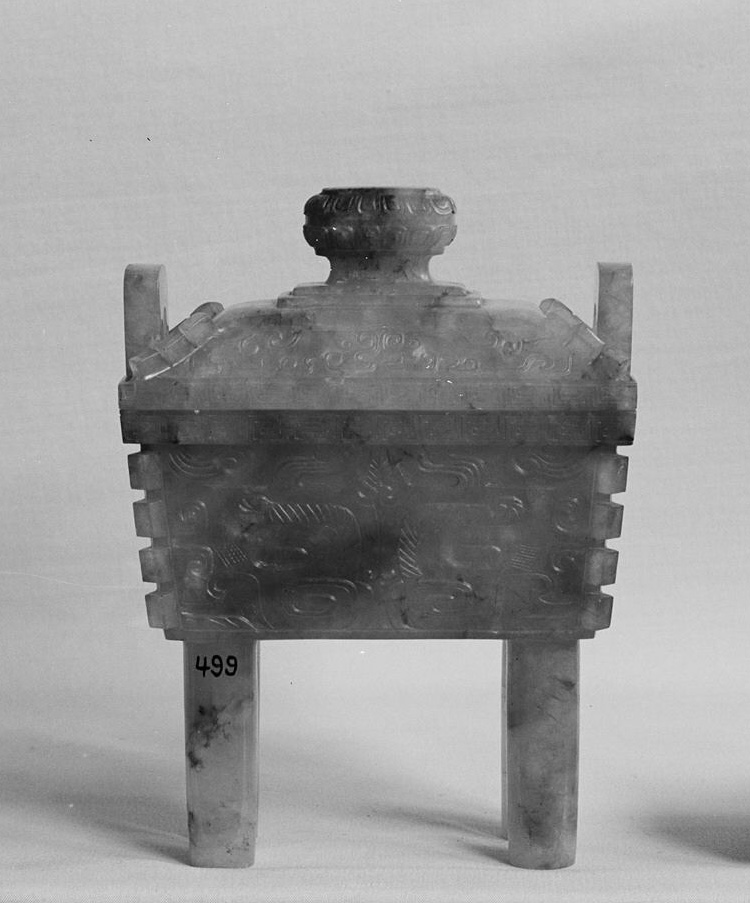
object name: urn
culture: chinese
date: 1736-1795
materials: gemstone, jade, wood